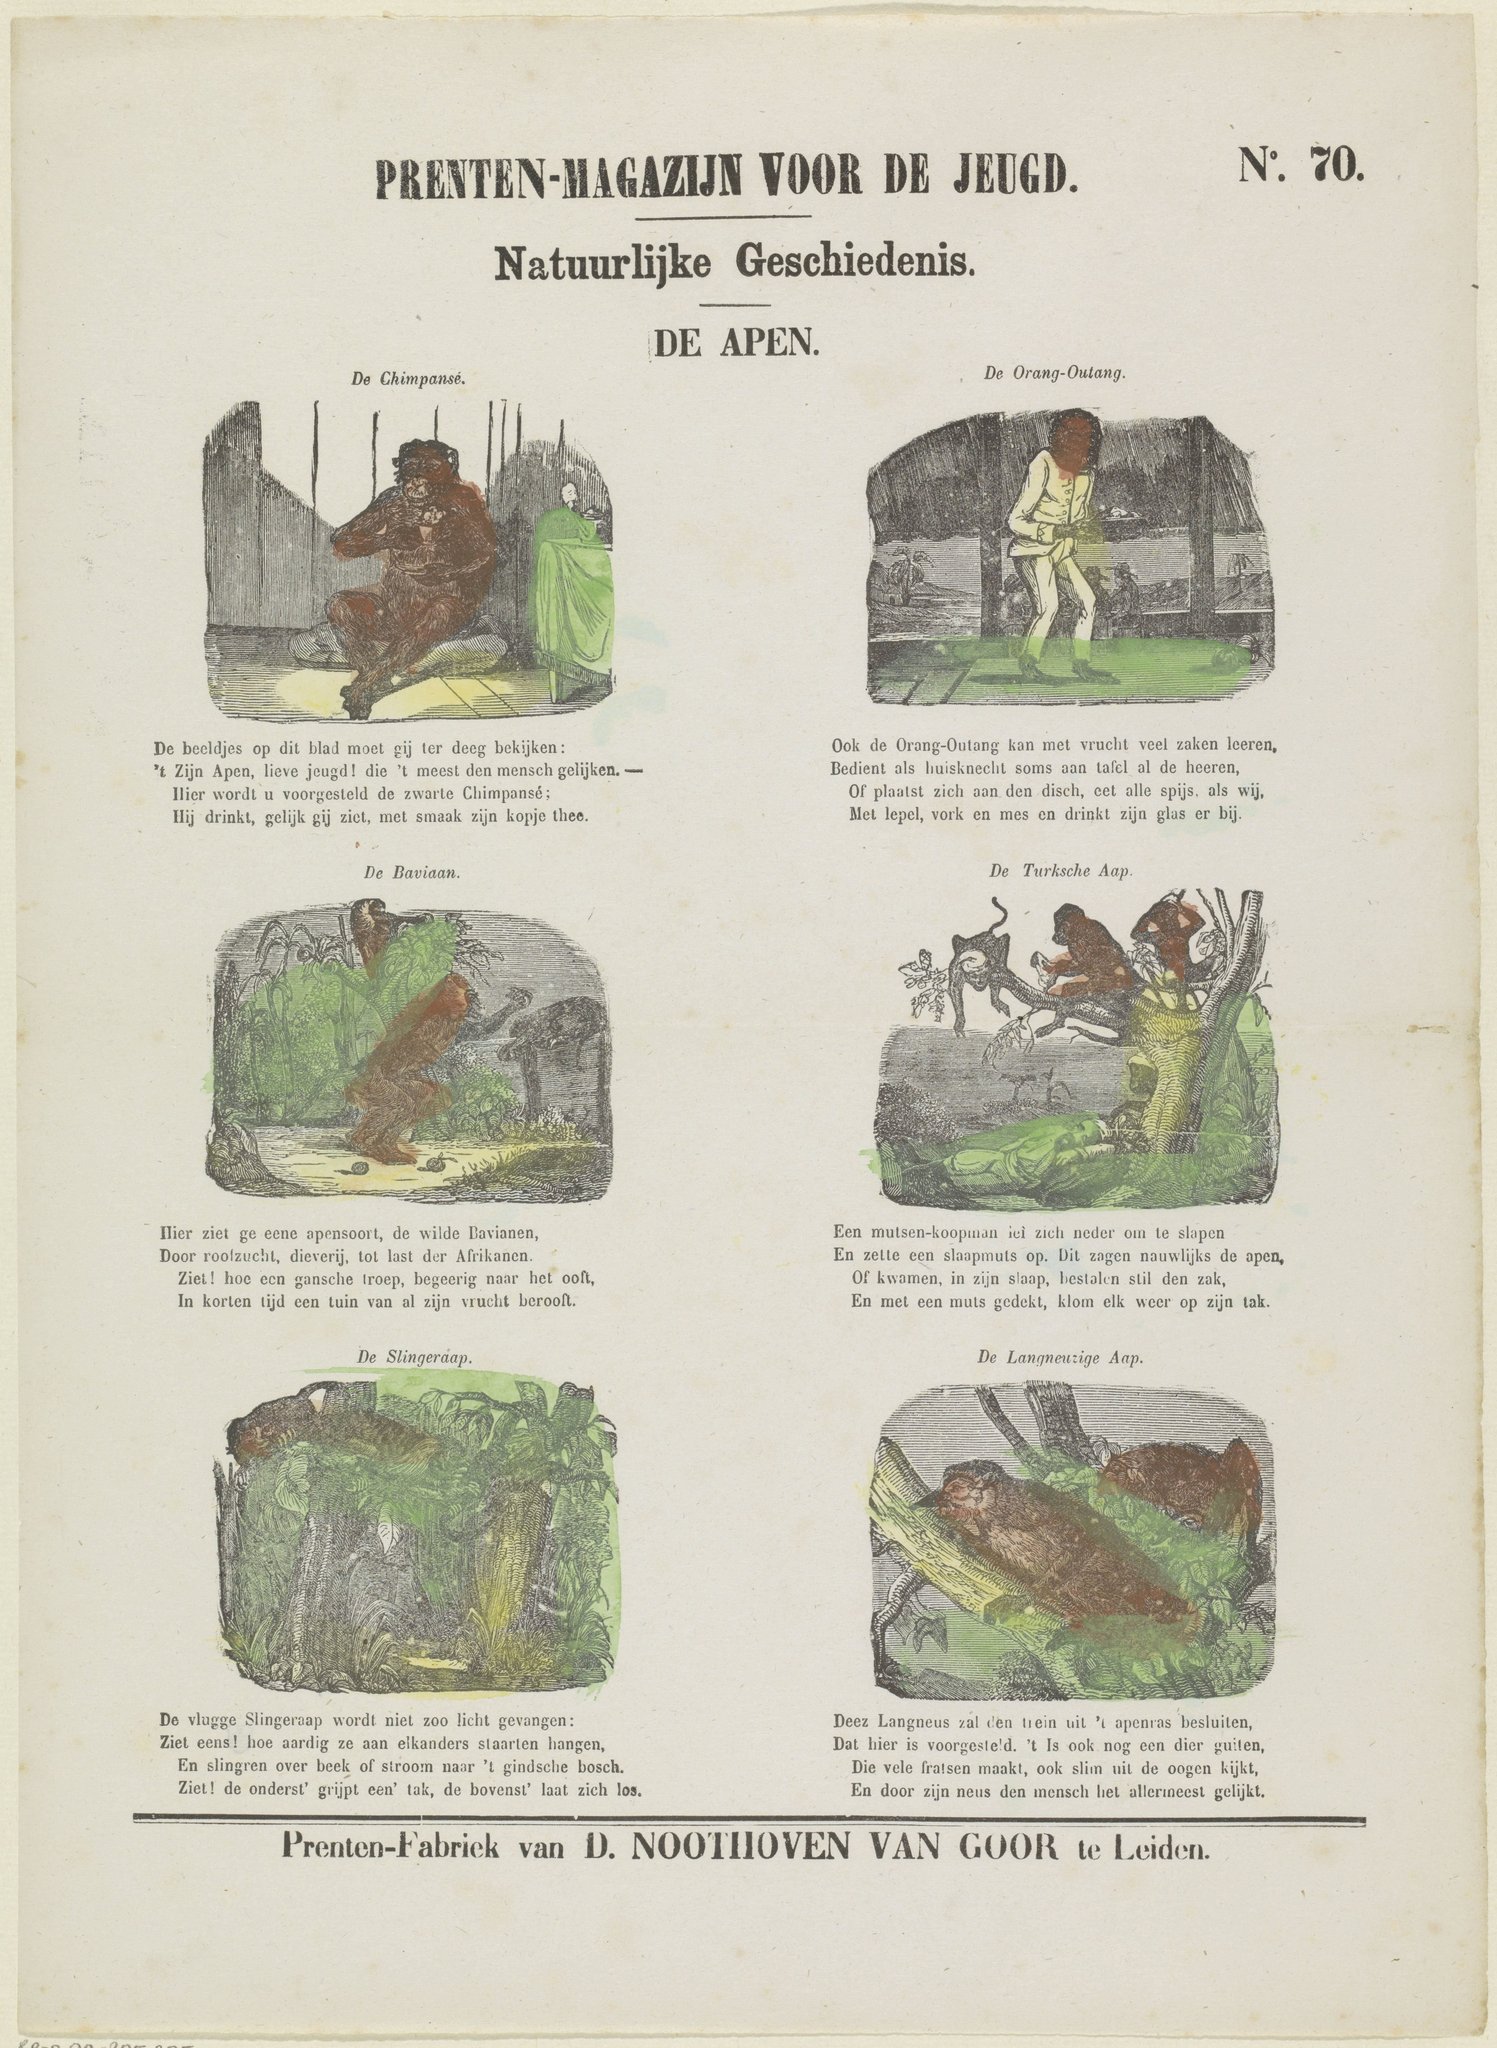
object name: print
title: Prenten-magazijn voor de jeugd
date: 1850-1881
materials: paper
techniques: colour, letterpress printing, engraving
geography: leiden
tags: monkeys, apes, animals acting as human beings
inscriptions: collector's mark: Lugt 2760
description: Blad met 6 voorstellingen van verschillende apen, zoals een chimpansee, een baviaan en een slingeraap. Boven elke voorstelling een titel en onder elke voorstelling een vierregelig vers. Genummerd rechtsboven: No. 70.